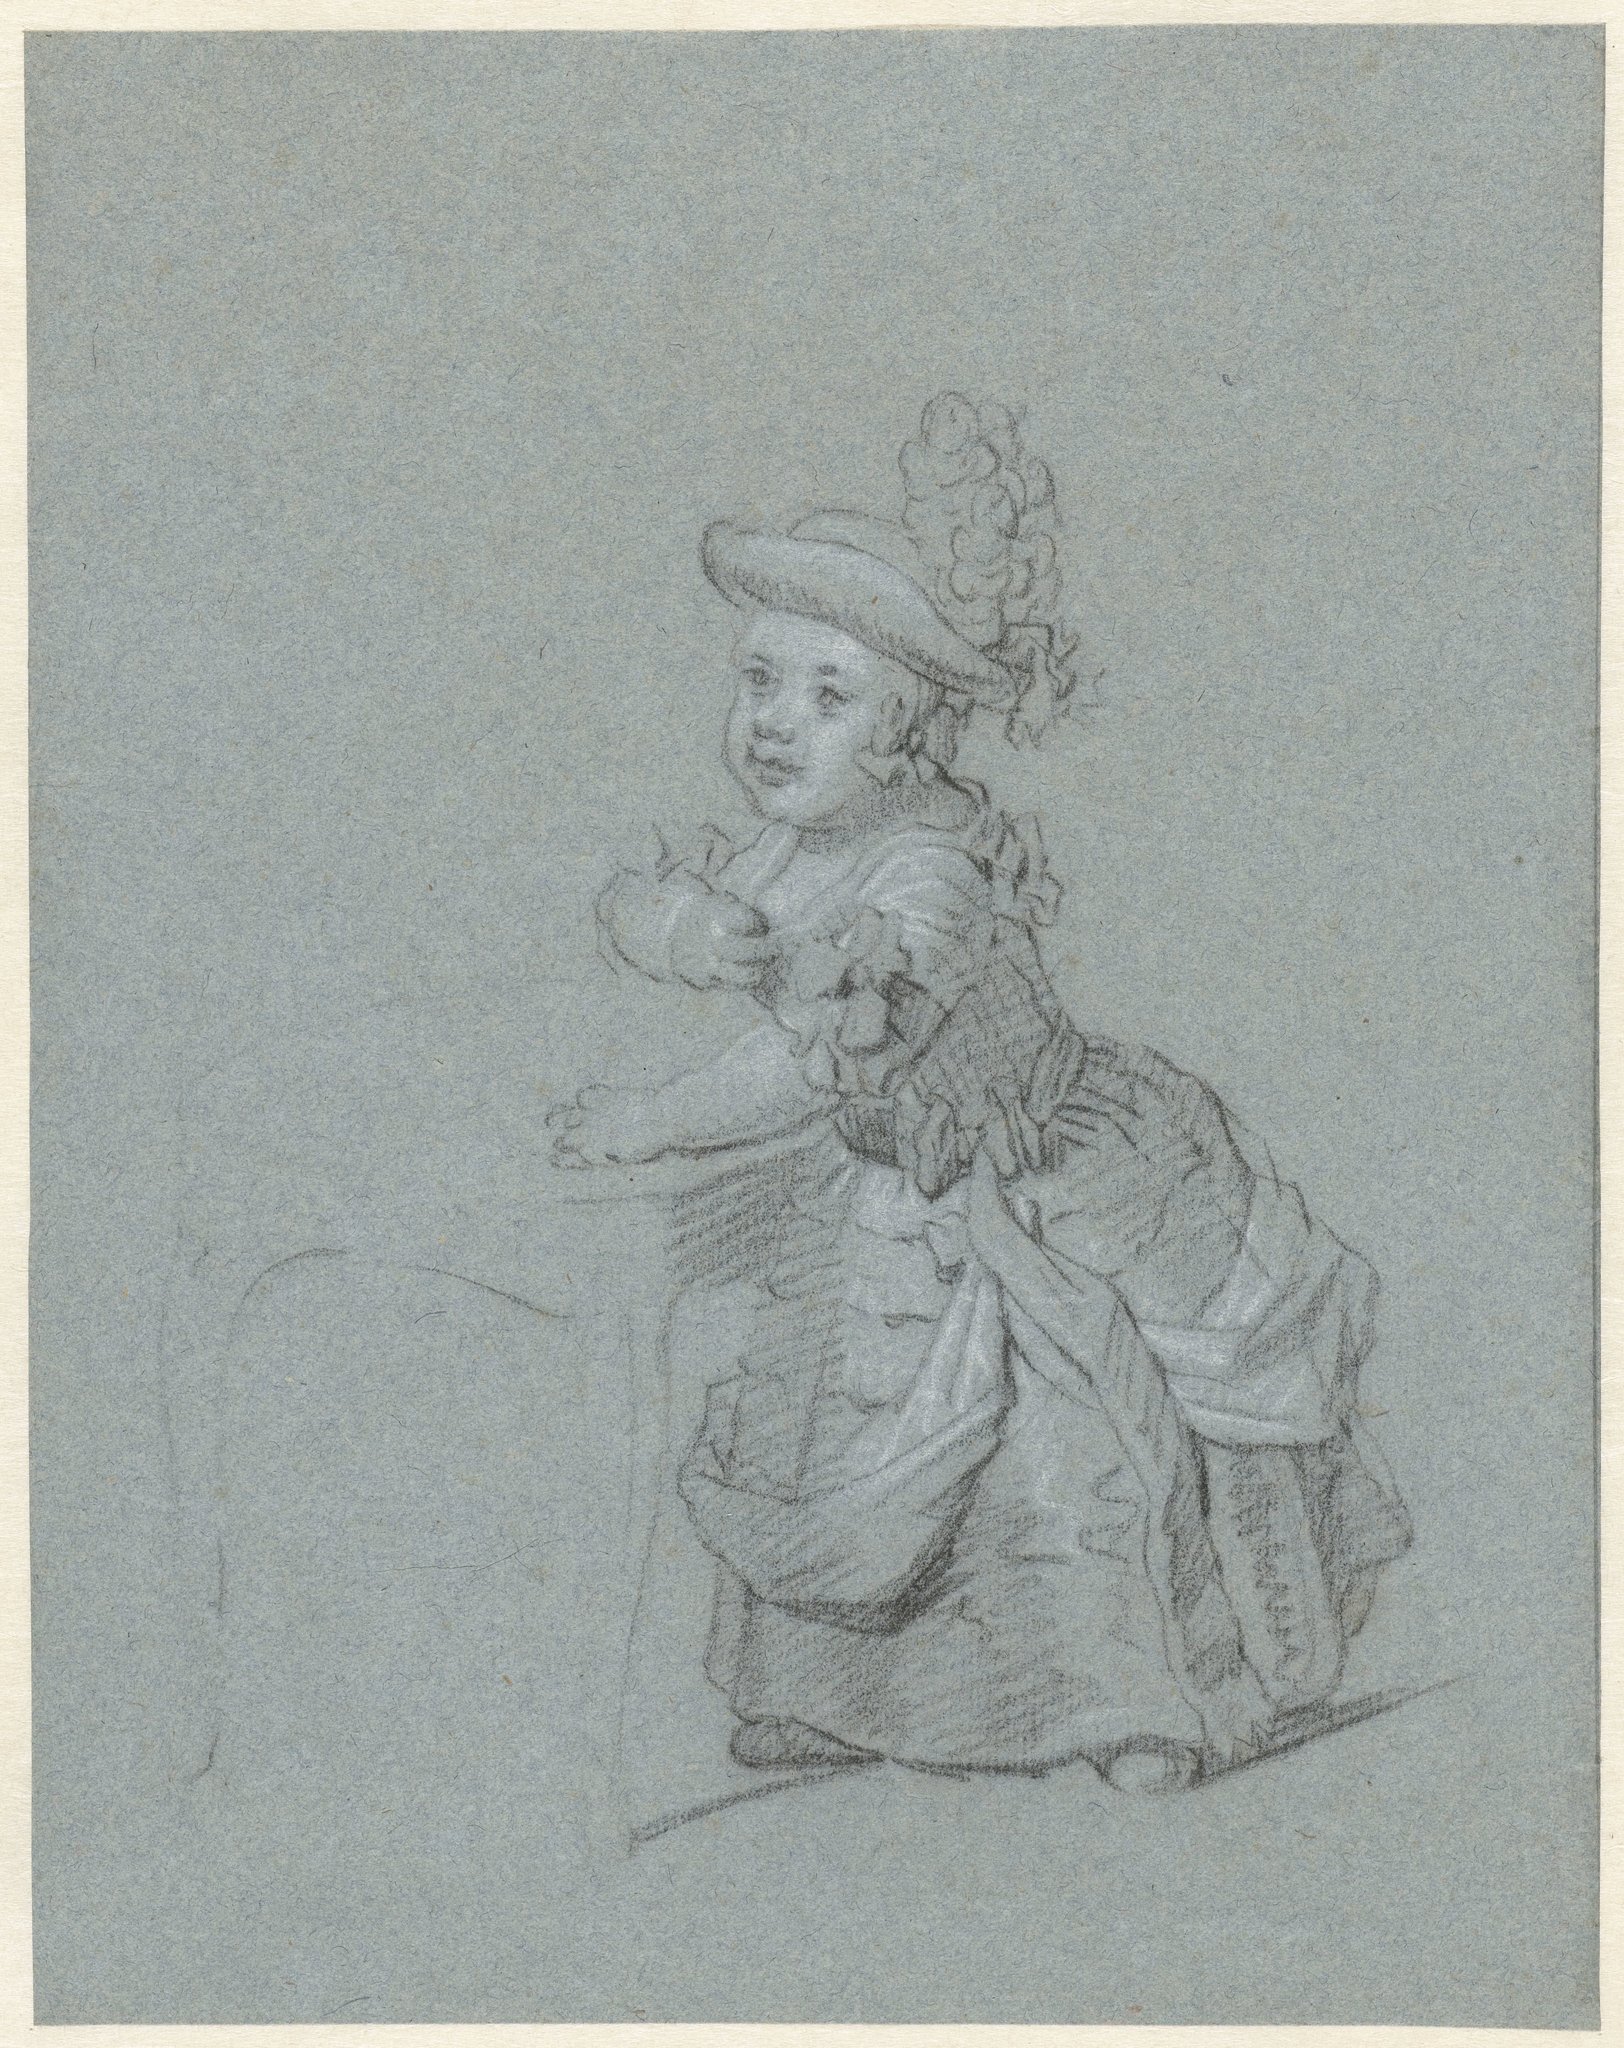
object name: drawing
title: Staand kind, zich vasthoudend aan een stoel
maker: hendrik pothoven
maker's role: draughtsman, painter, print maker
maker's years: 1725-1807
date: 1735-1807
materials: chalk, paper